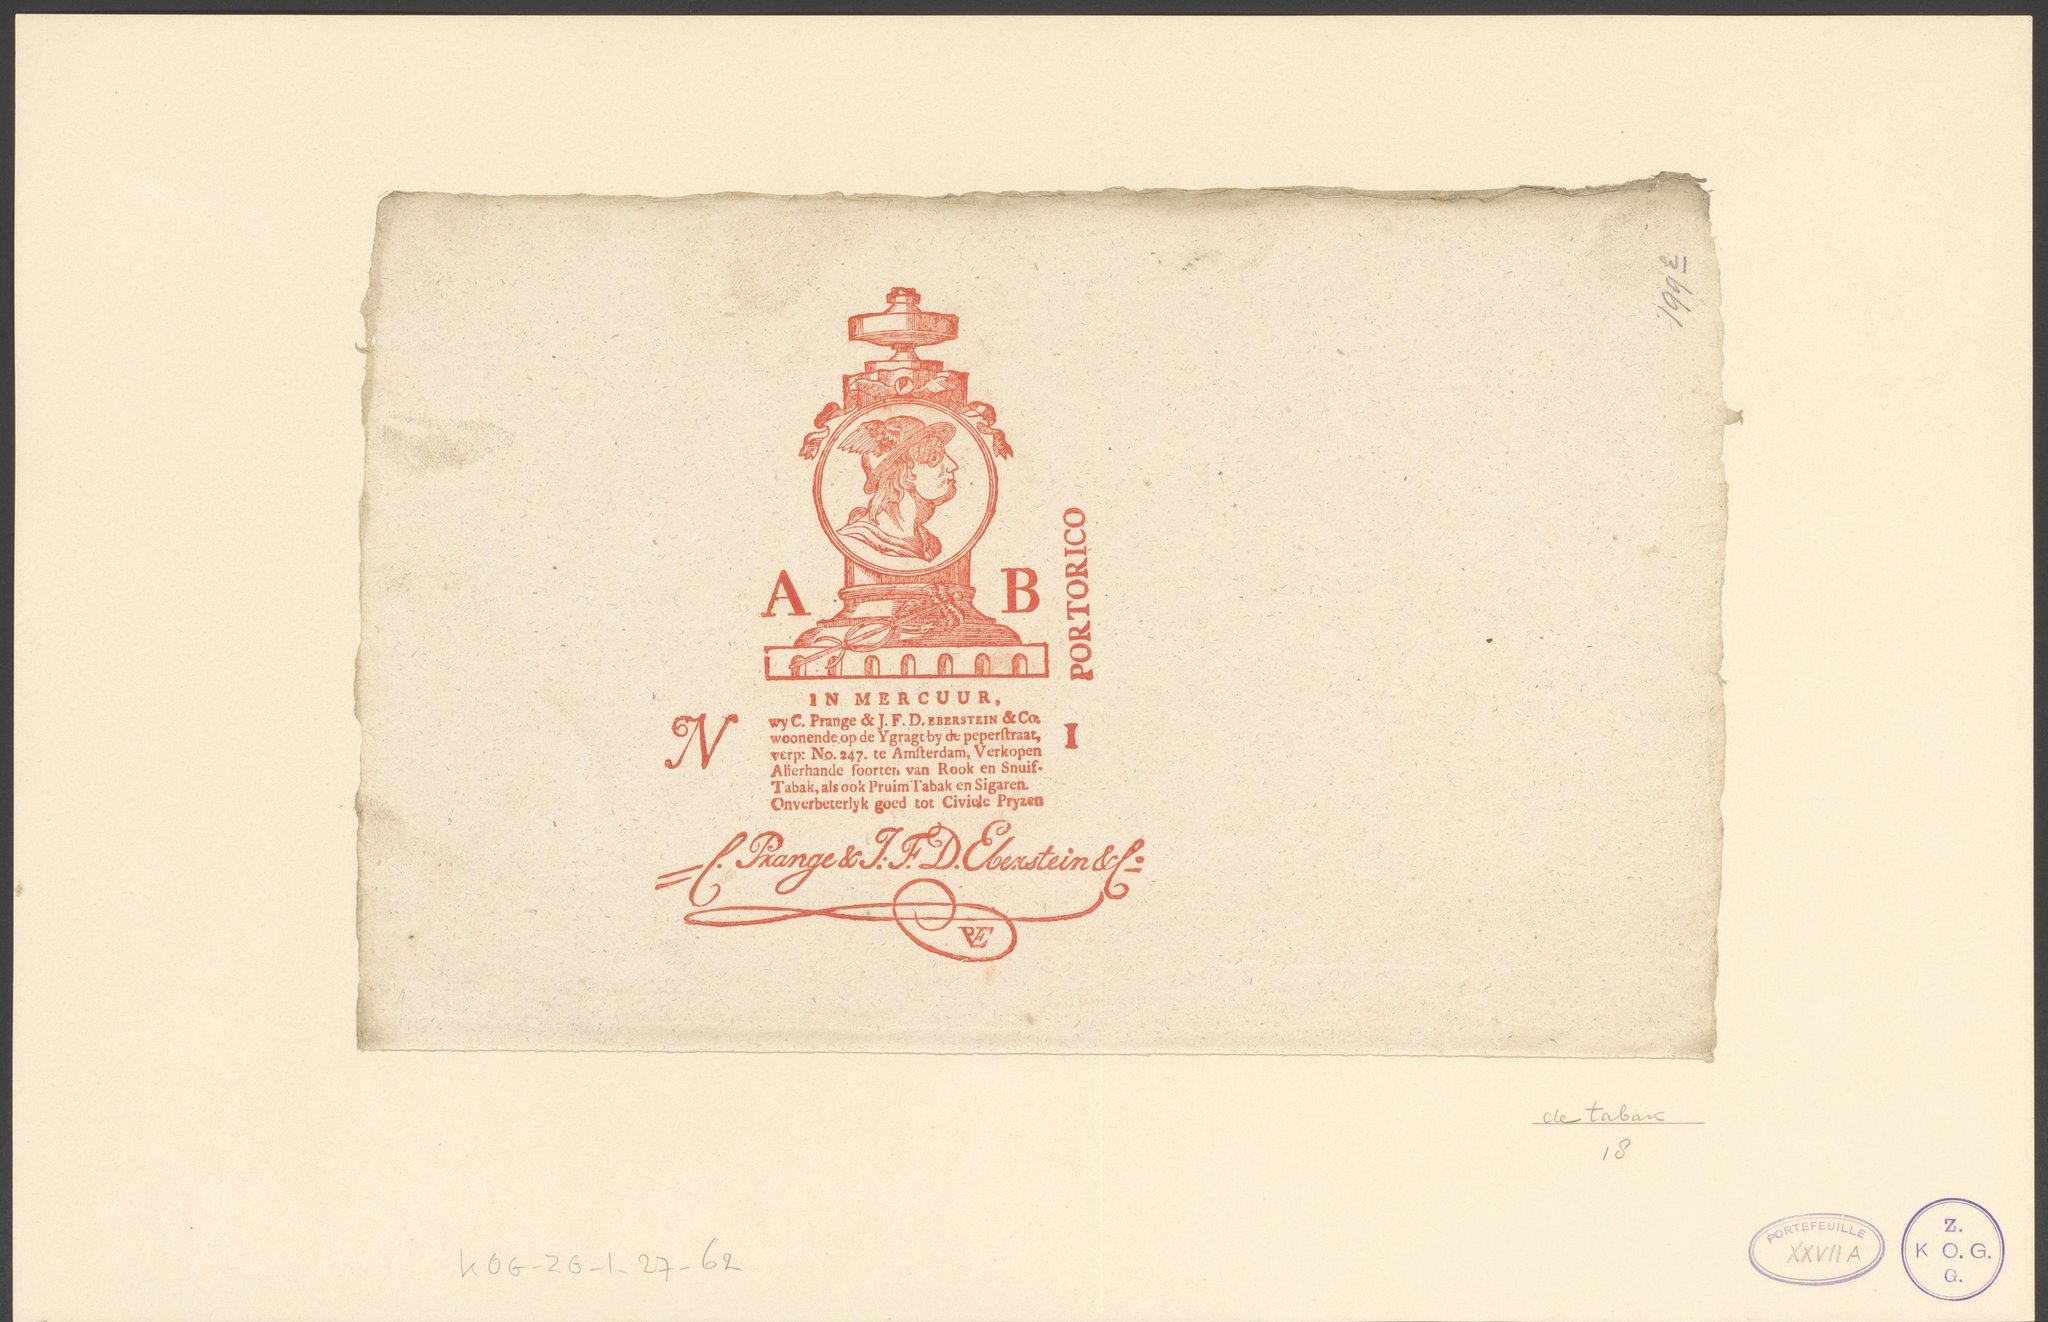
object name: label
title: Etiket voor tabaksverpakking van Christoffel Prange en J.F.D. Eberstein & Co.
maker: Anonymous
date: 1750-1790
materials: paper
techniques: letterpress printing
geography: netherlands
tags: tobacco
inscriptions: collector's mark, collector's mark: Lugt 1641